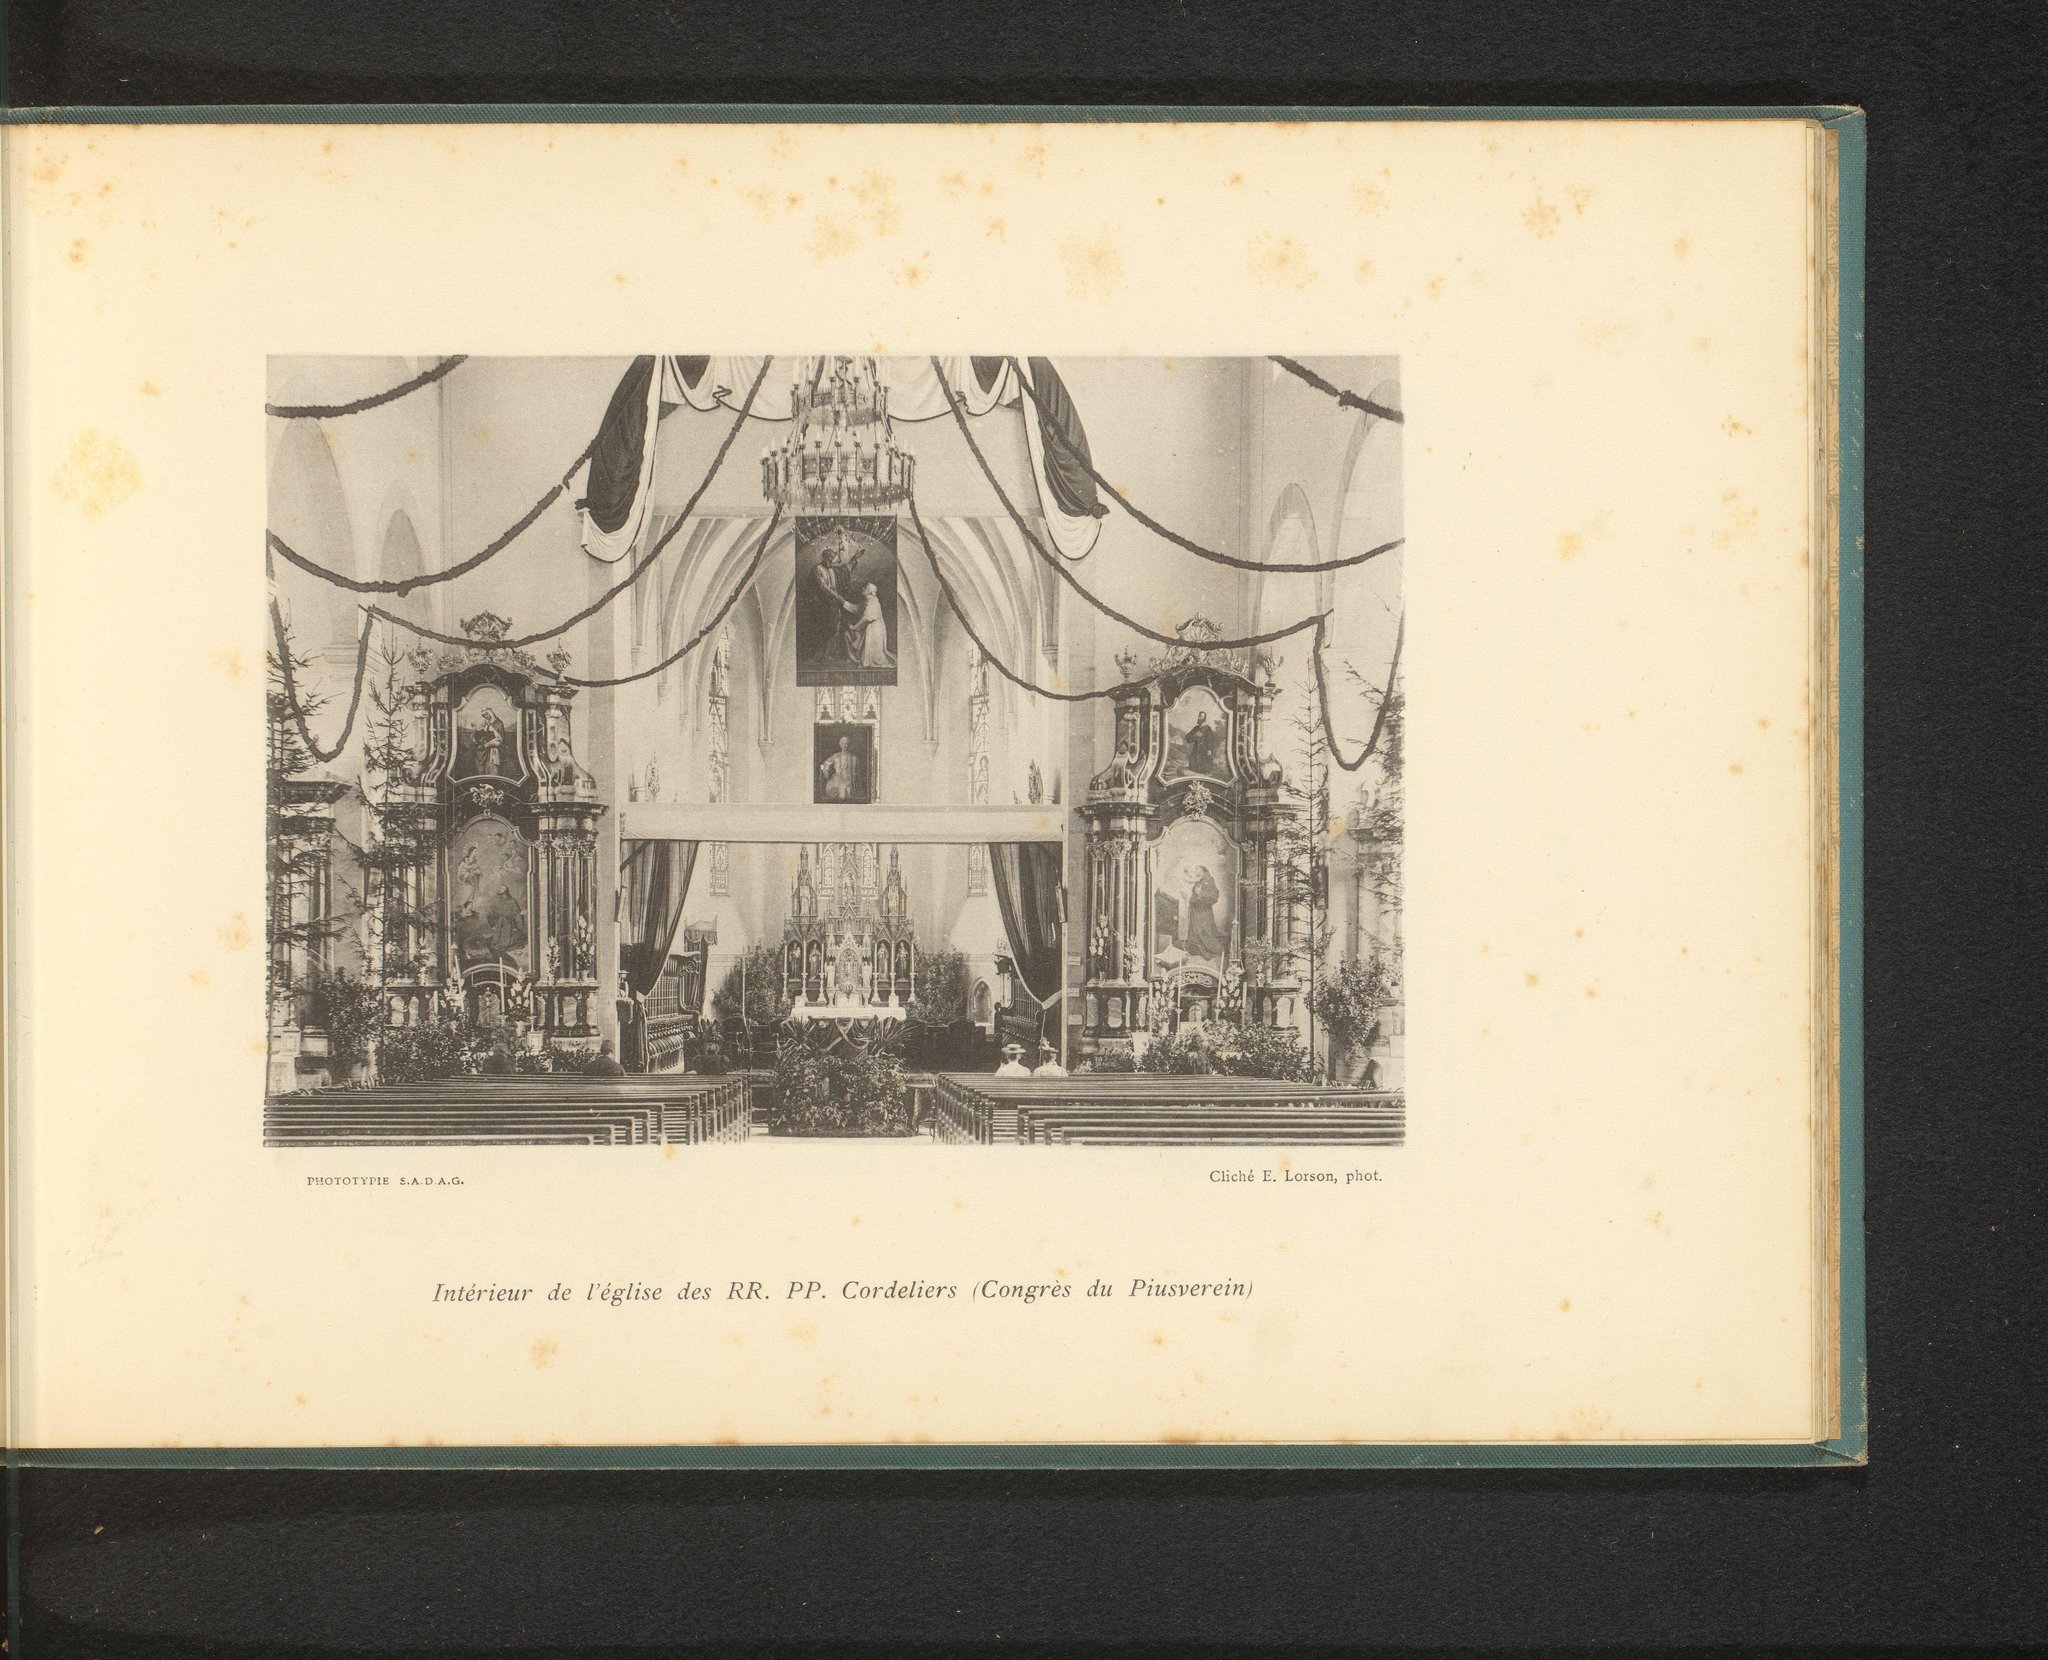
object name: page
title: Interieur van de L’Eglise des Cordeliers in Fribourg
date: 1897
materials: paper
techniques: photograph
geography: fribourg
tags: interior of church